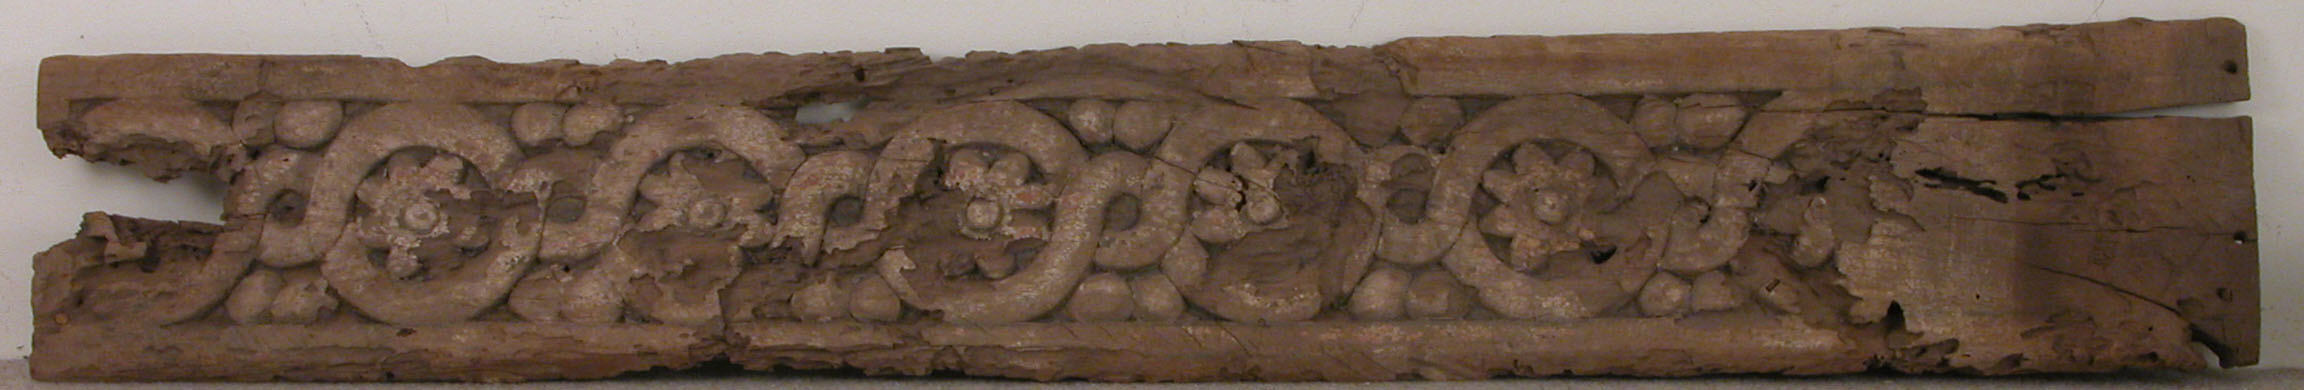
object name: panel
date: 501-700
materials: wood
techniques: carving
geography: egypt